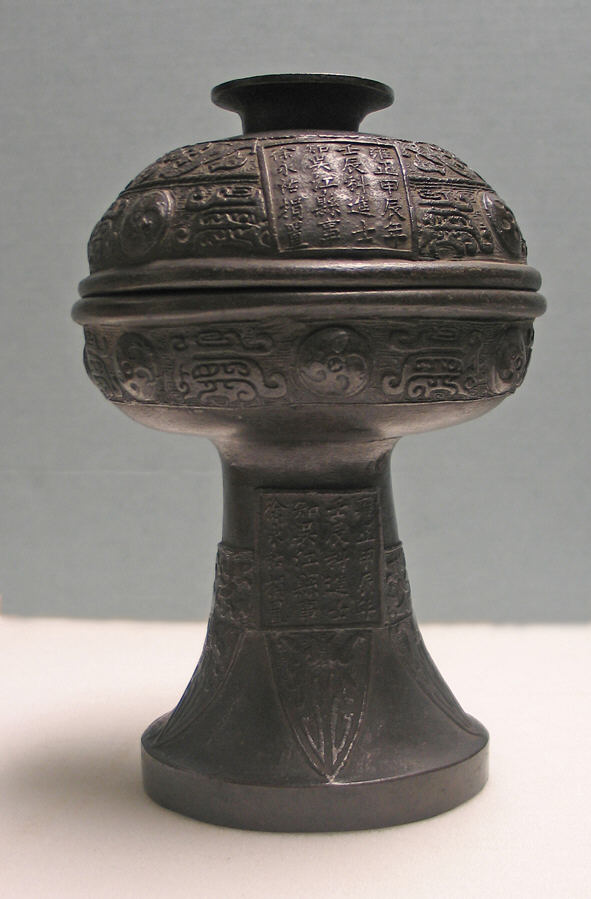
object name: covered vessel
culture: chinese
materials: bronze